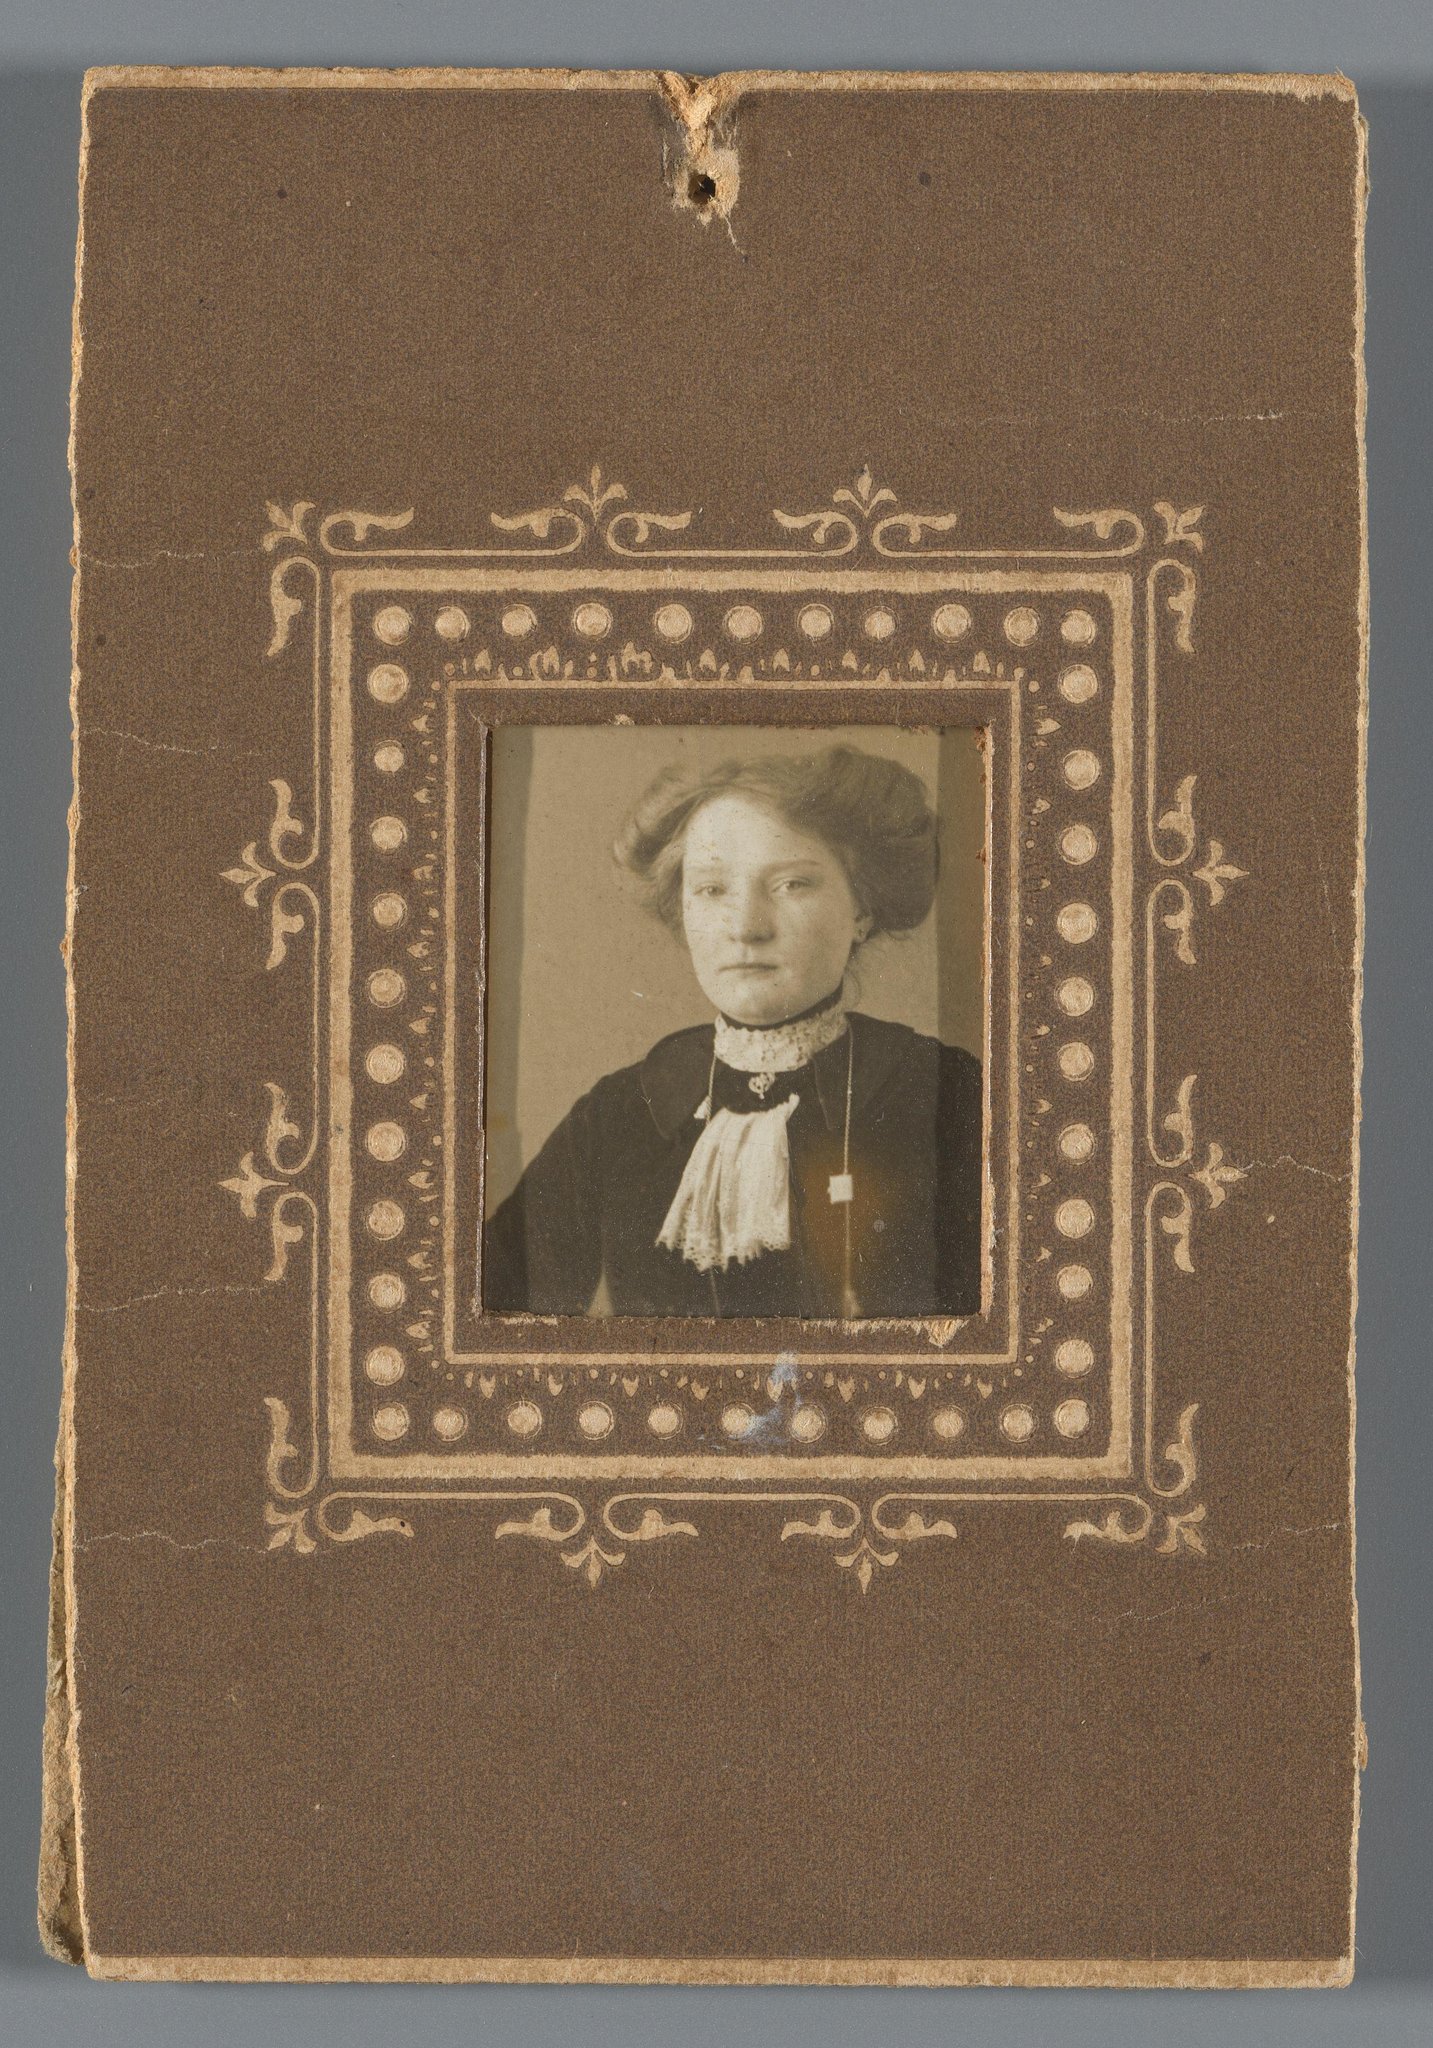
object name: snapshot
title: Portret van een onbekende vrouw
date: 1913-1925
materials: photographic support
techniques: gelatin silver print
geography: amsterdam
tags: amsterdam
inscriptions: stamp: ‘AMERICAN AUTOMATIC FOTOGRAFIE / Kalverstraat 155’